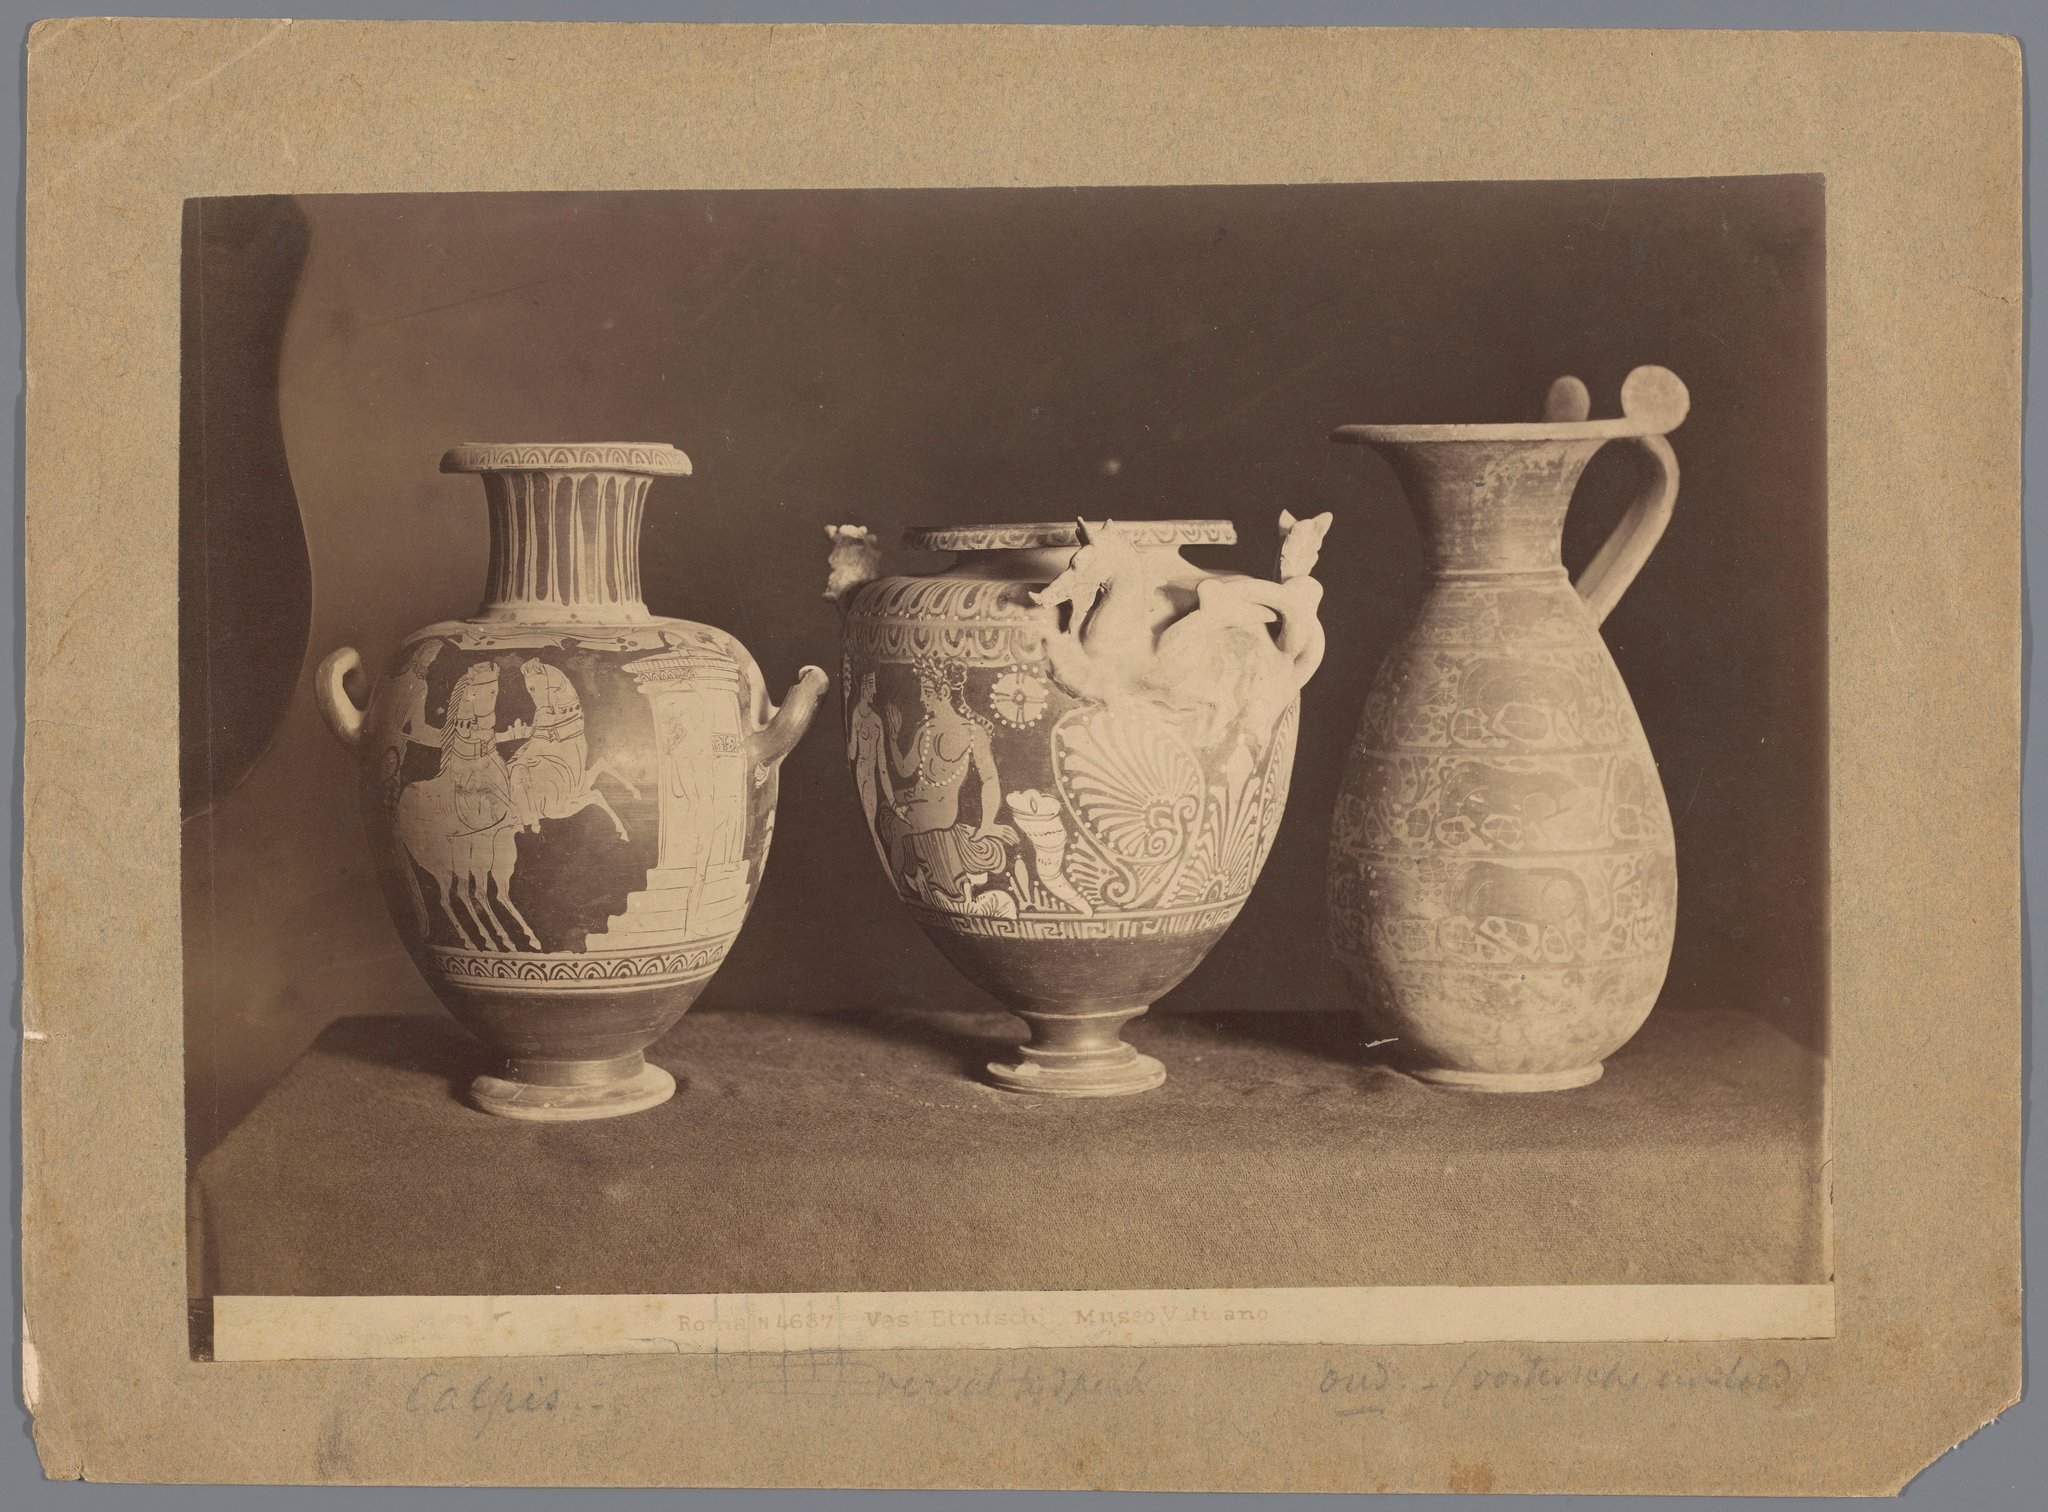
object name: photograph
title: Vasi Etruschi Museo Vaticano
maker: Anonymous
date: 1875-1900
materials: cardboard, photographic support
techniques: albumen print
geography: vatican museums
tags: horse, container of ceramics: jar, jug, pot, vase, ornamenting, decorating ~ applied arts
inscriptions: inscription: ‘Calpis. [...] tijdperk oud. [...]’, number: ‘Roma N 4687’, collector's mark: Lugt 3937